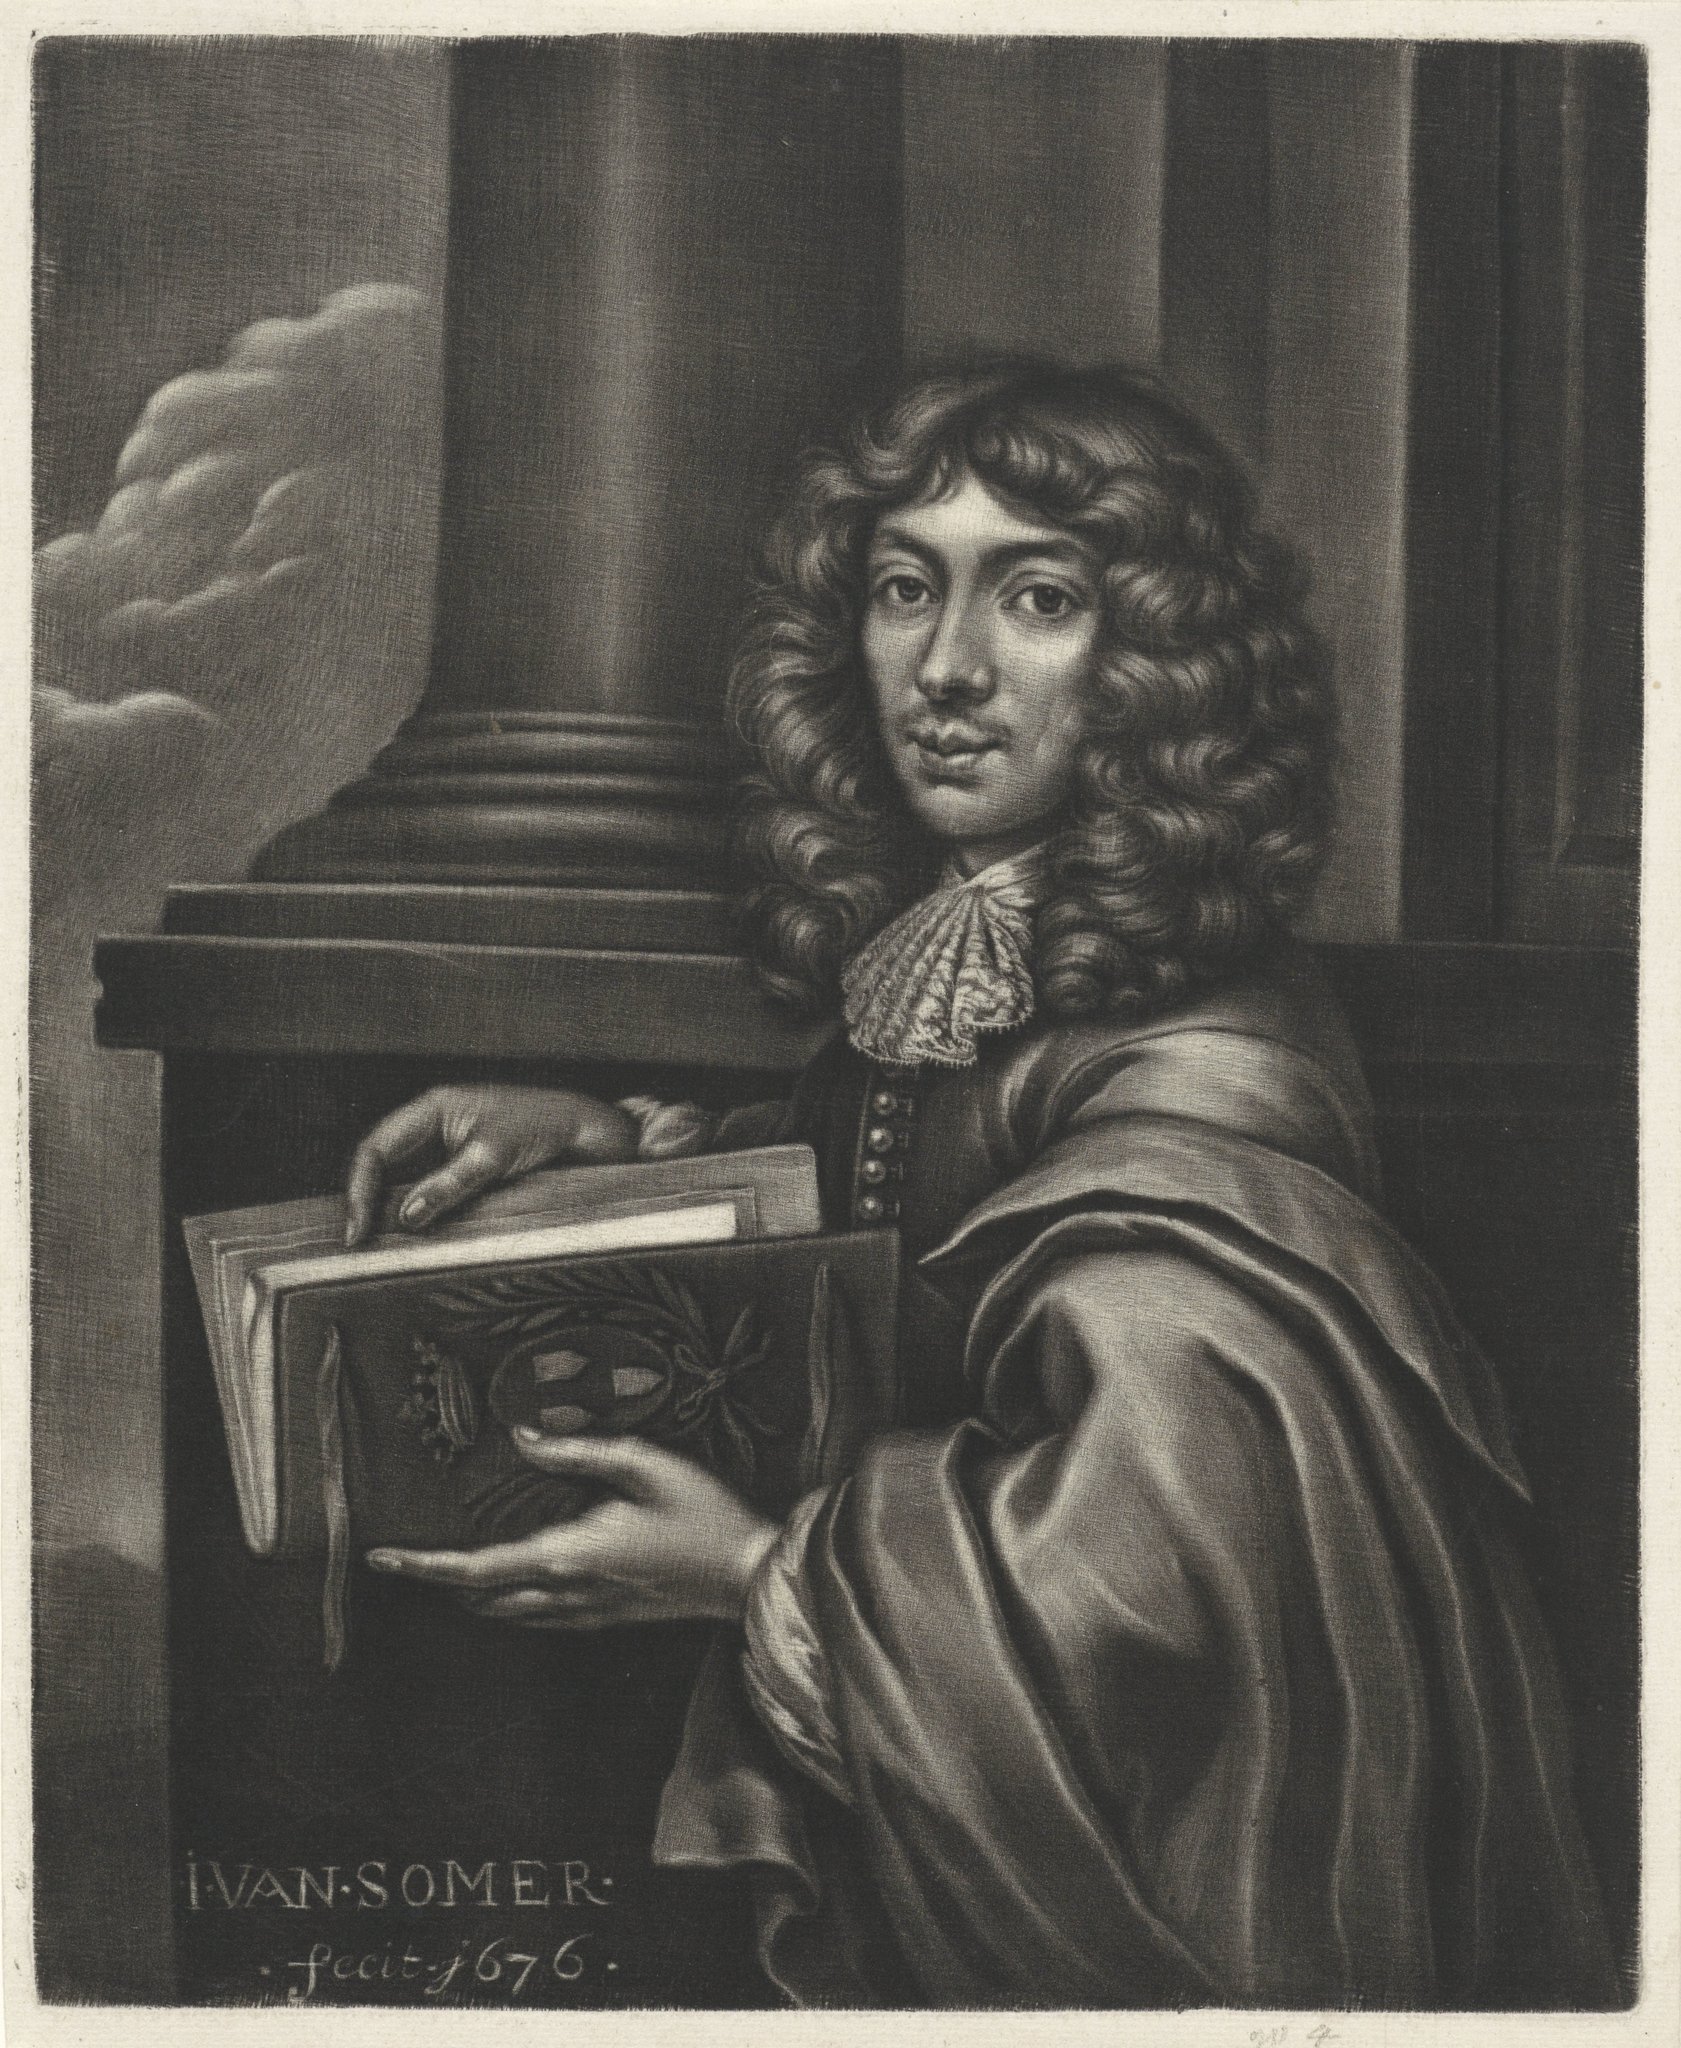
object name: print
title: Portret van Karel XI, koning van Zweden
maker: jan van somer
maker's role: draughtsman, print maker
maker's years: 1645-1699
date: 1676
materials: paper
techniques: mezzotint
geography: amsterdam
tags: book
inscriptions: collector's mark: Lugt 2228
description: Karel XI, koning van Zweden voor een zuil met een boek in de hand.